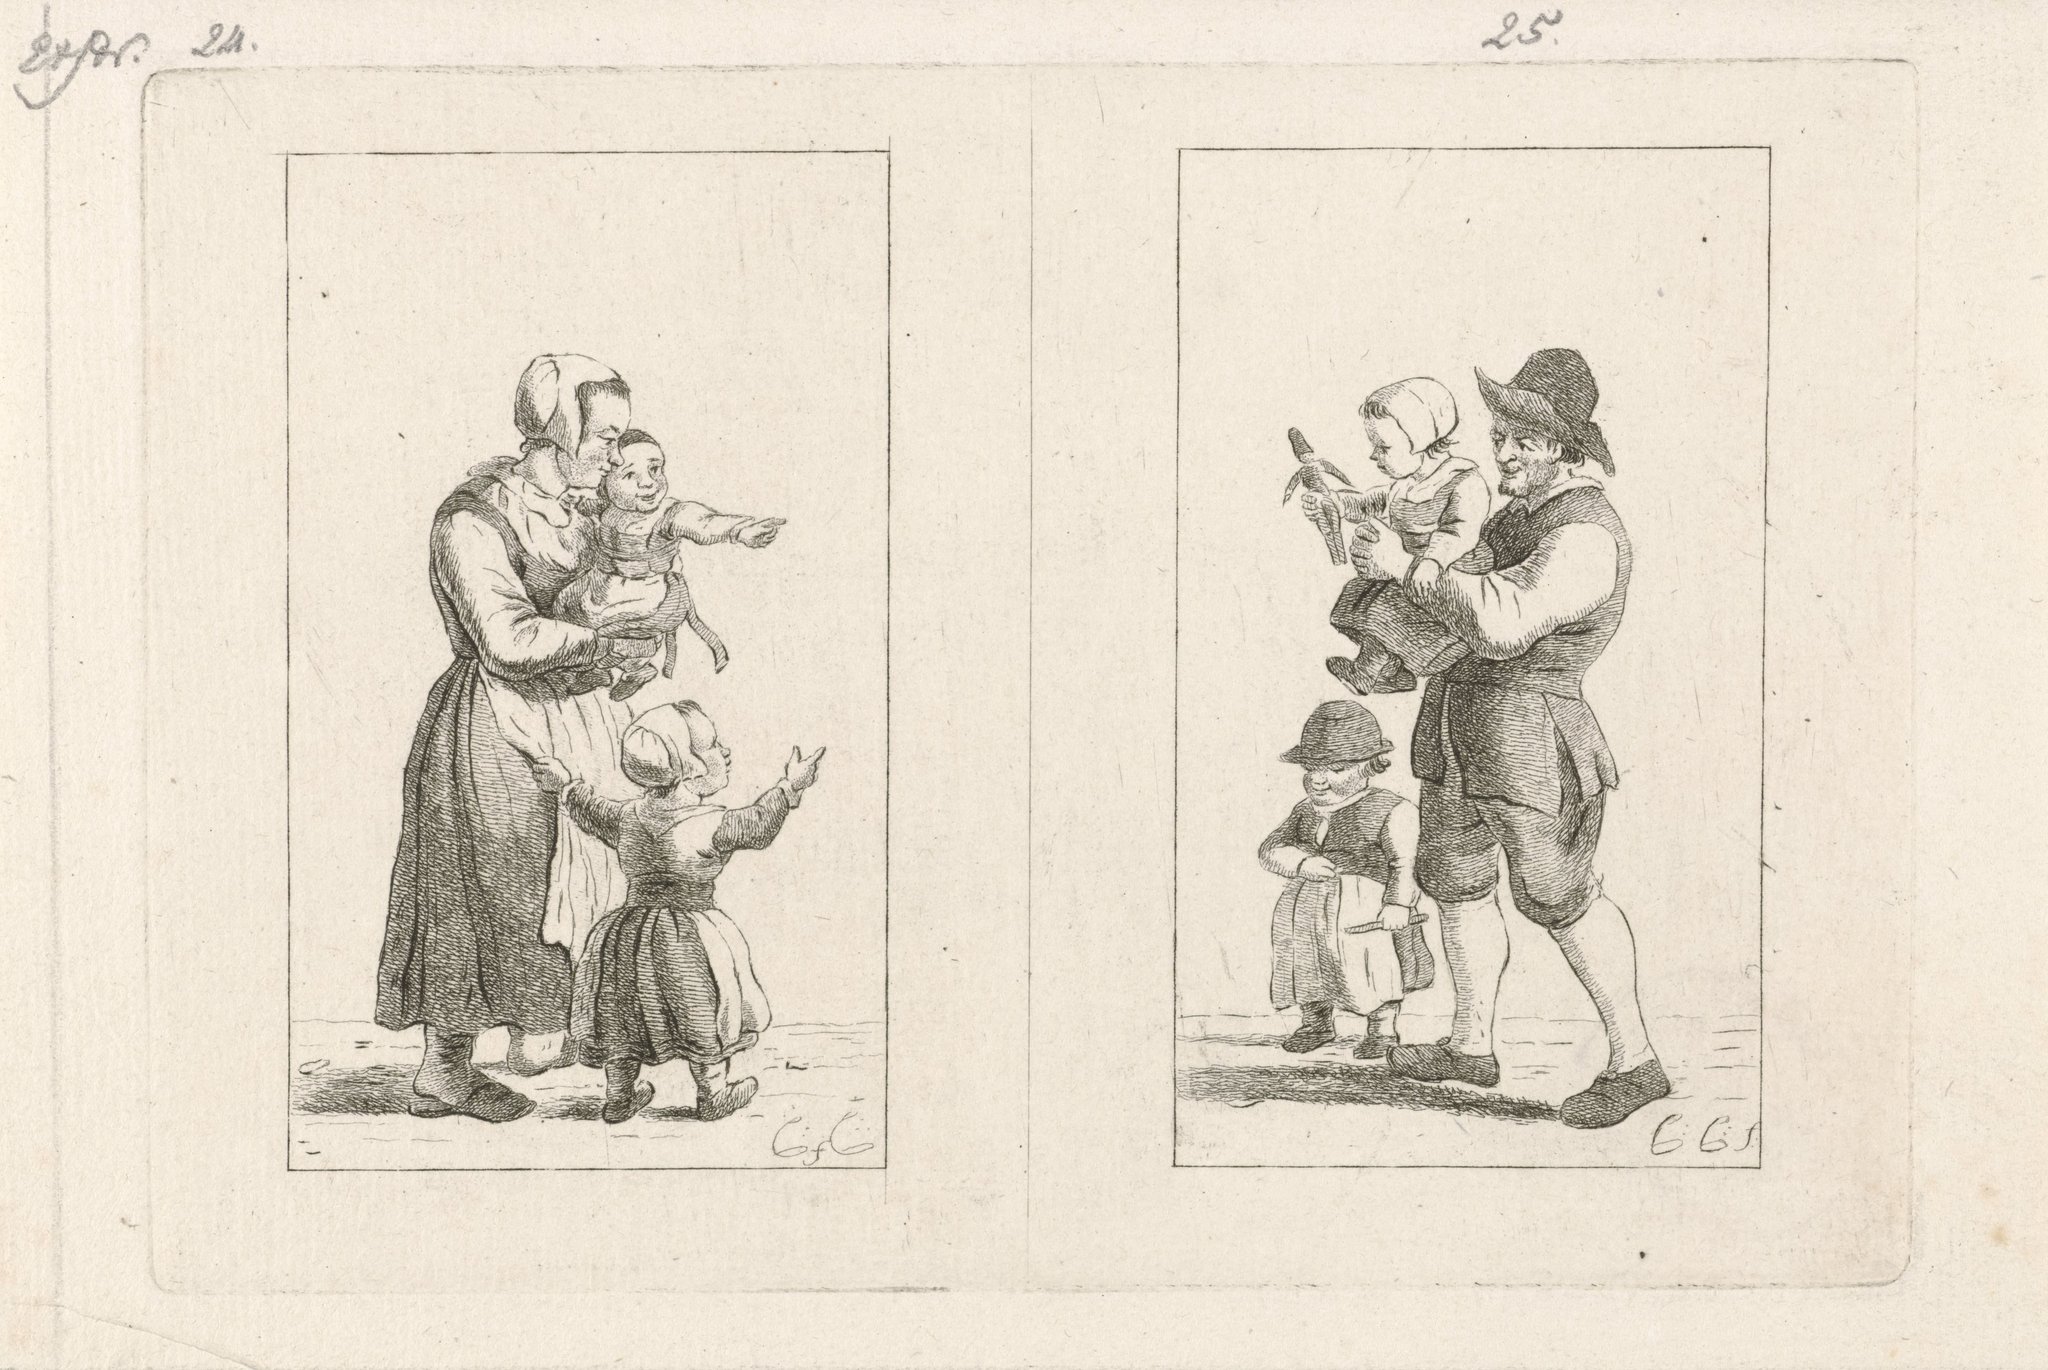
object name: print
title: Twee voorstellingen van een ouder met twee kinderen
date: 1779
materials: paper, pencil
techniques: etching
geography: leiden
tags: mother and baby or young child, father-love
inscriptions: collector's mark: Lugt 240, number: ‘Etsdr. 24. 25.’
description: Twee voorstellingen van van een ouder met twee kinderen: links een moeder en rechts een vader met elk een kind op de arm en een aan hun zij.